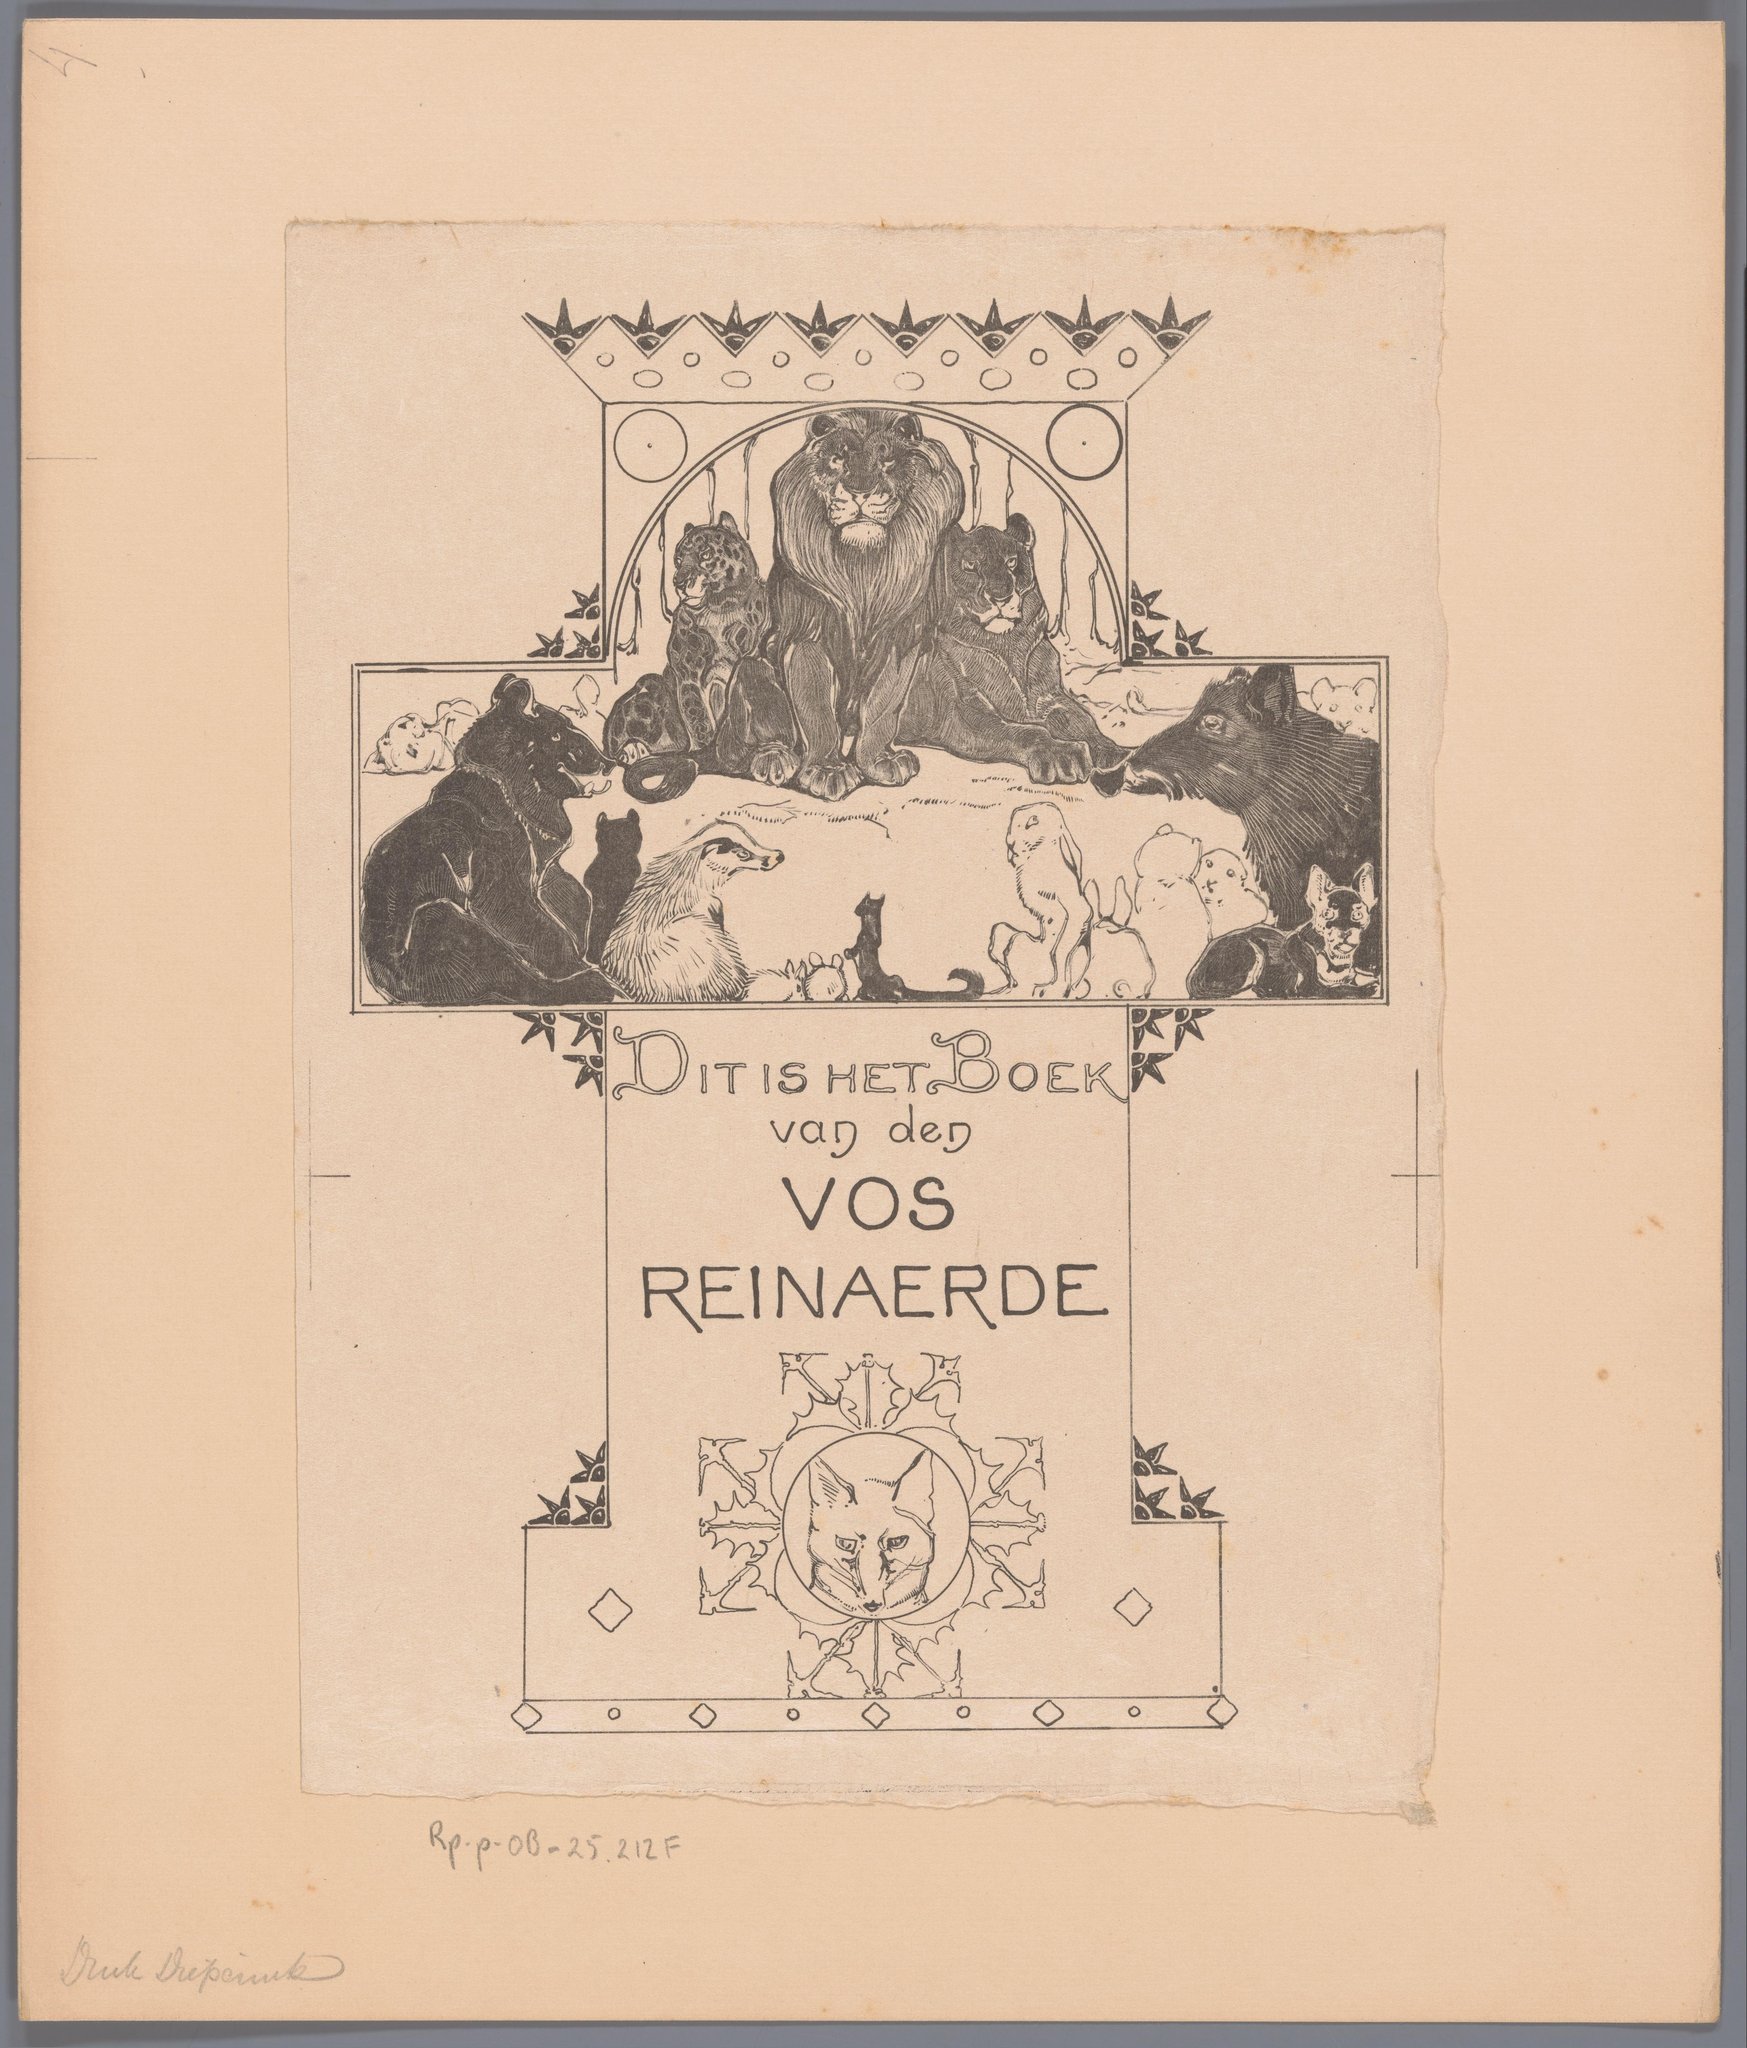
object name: titelblad, titelpagina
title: Dit is het boek van den vos Reinaerde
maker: bernard willem wierink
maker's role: draughtsman, print maker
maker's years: 1856-1939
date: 1910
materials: paper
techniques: lithograph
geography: amsterdam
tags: fable of reynard the fox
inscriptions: collector's mark: Lugt 2228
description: Niet gebruikt ontwerp voor: Streuvels, Stijn (Frank Lateur). Reinaert de Vos naar verschillende uitgaven van het middeleeuwsche epos. Amsterdam: L.J. Veen, 1910.